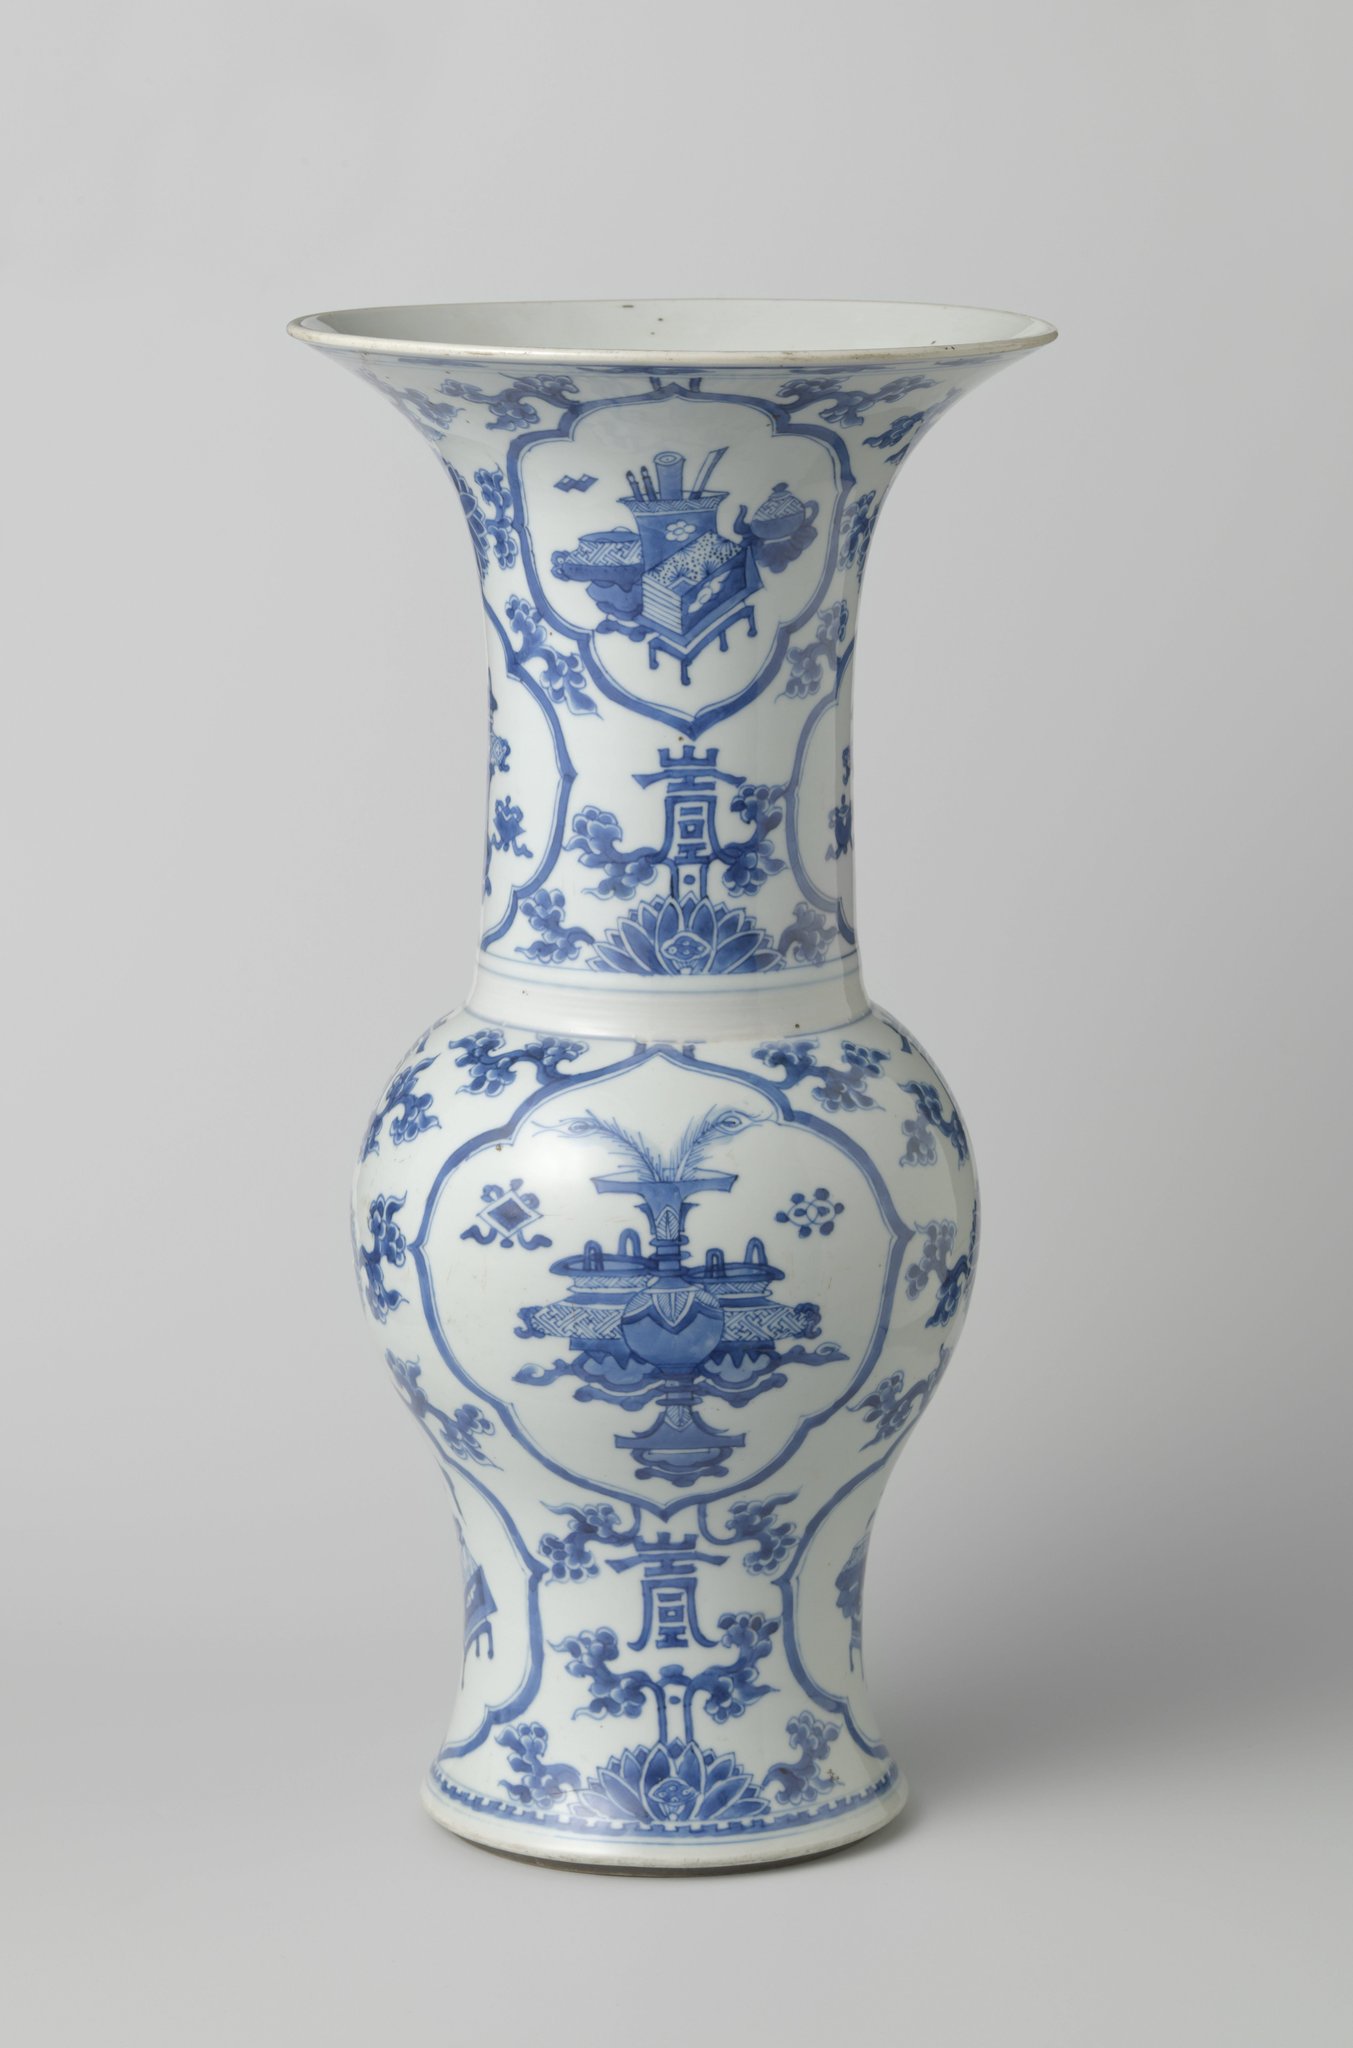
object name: bekervaas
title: Baluster beaker vase with flower scrolls and precious objects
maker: Anonymous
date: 1680-1720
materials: cobalt, glaze, paint, porcelain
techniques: firing, turning, vitrification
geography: china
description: Balustervormige bekervaas van porselein met wijde nek, beschilderd in onderglazuur blauw. De buik en nek zijn bedekt met gestileerde chrysantranken waarin het 'shou' karakter is verwerkt; tussen de ranken acht gelobde cartouches met kostbaarheden (ruit, parel, muzieksteen, boeken) en antiquiteiten (vaas met pauwenveren, boeken, wierookbrander, objecten van een geleerde). Blauw-wit.